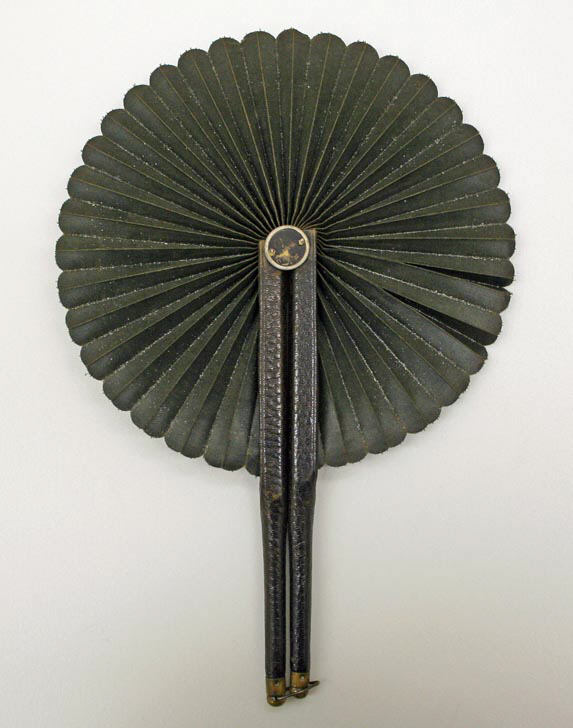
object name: mourning fan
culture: american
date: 1801-1900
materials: cotton, leather